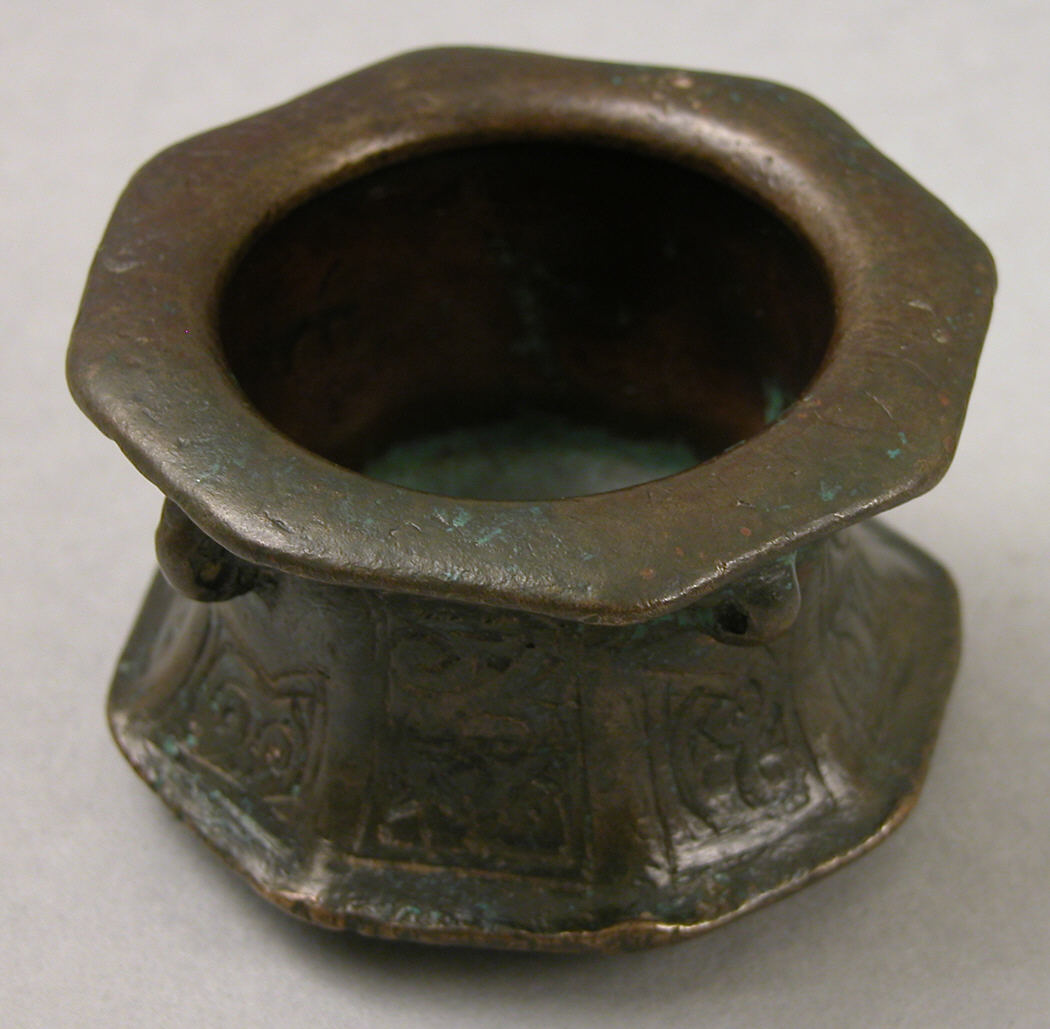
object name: mortar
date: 1001-1300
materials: bronze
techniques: casting, engraving, lacquer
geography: iran